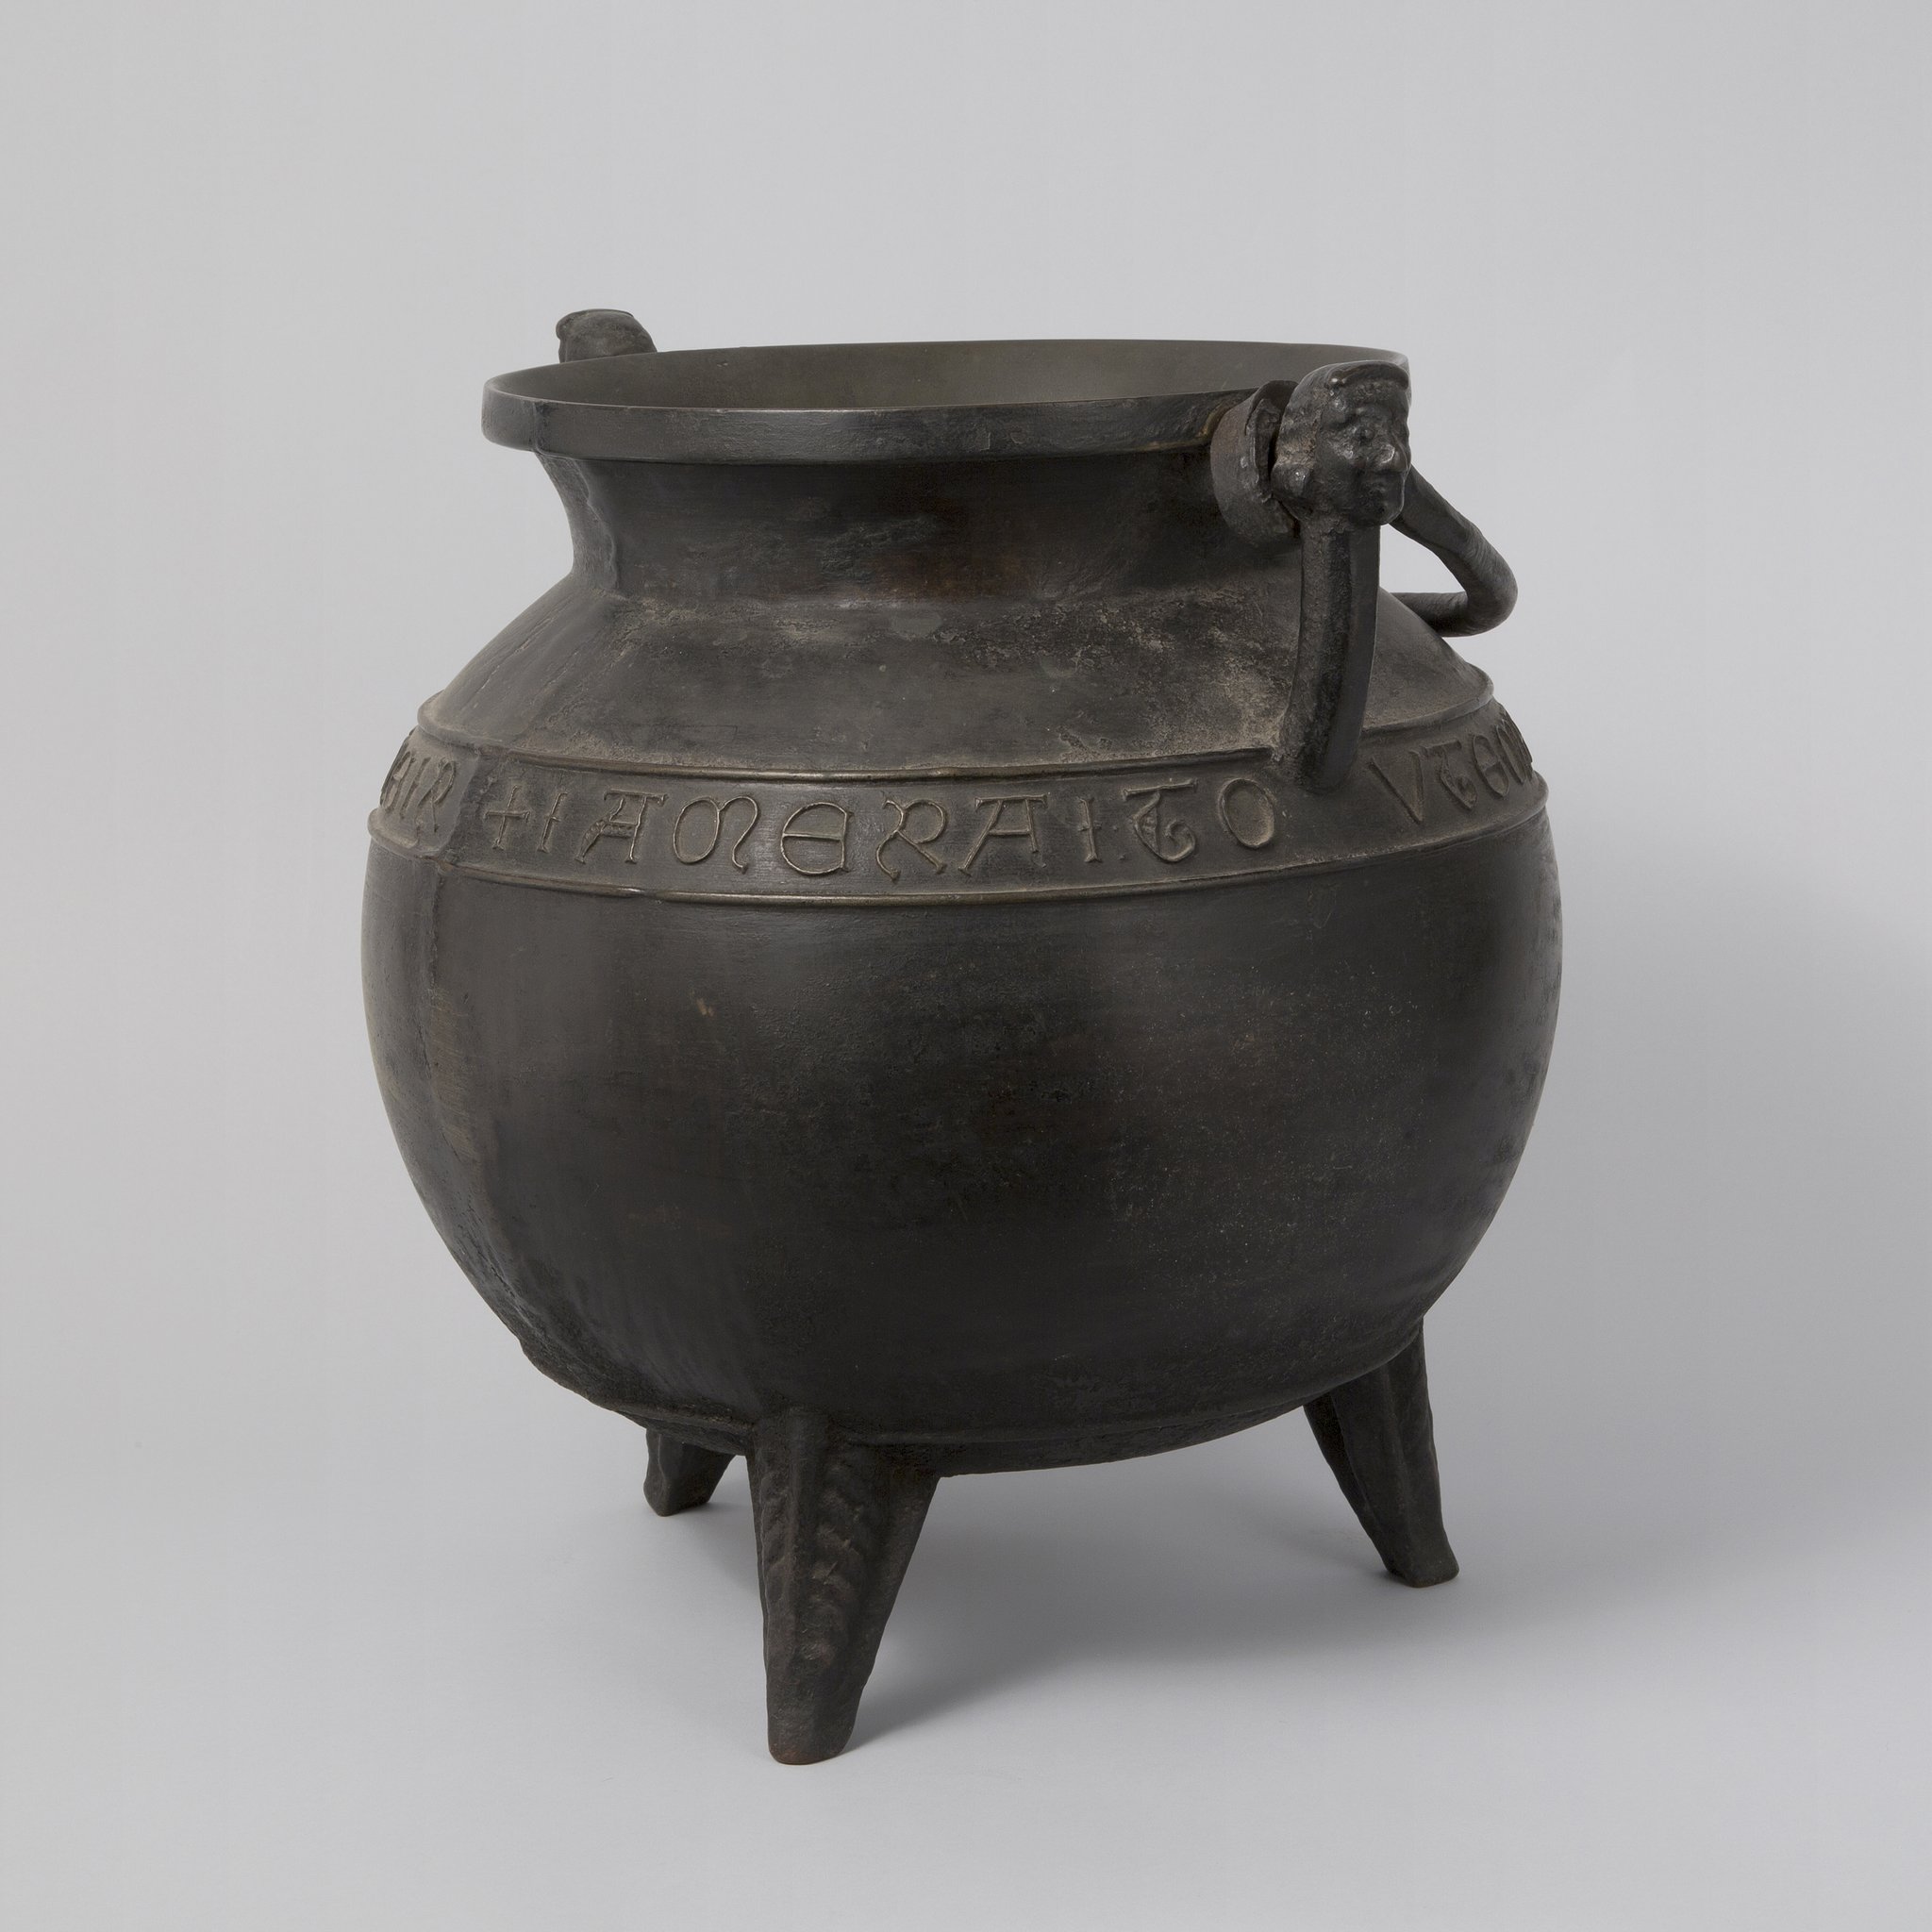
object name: cauldron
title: Caldron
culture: french or south netherlandish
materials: bronze, iron